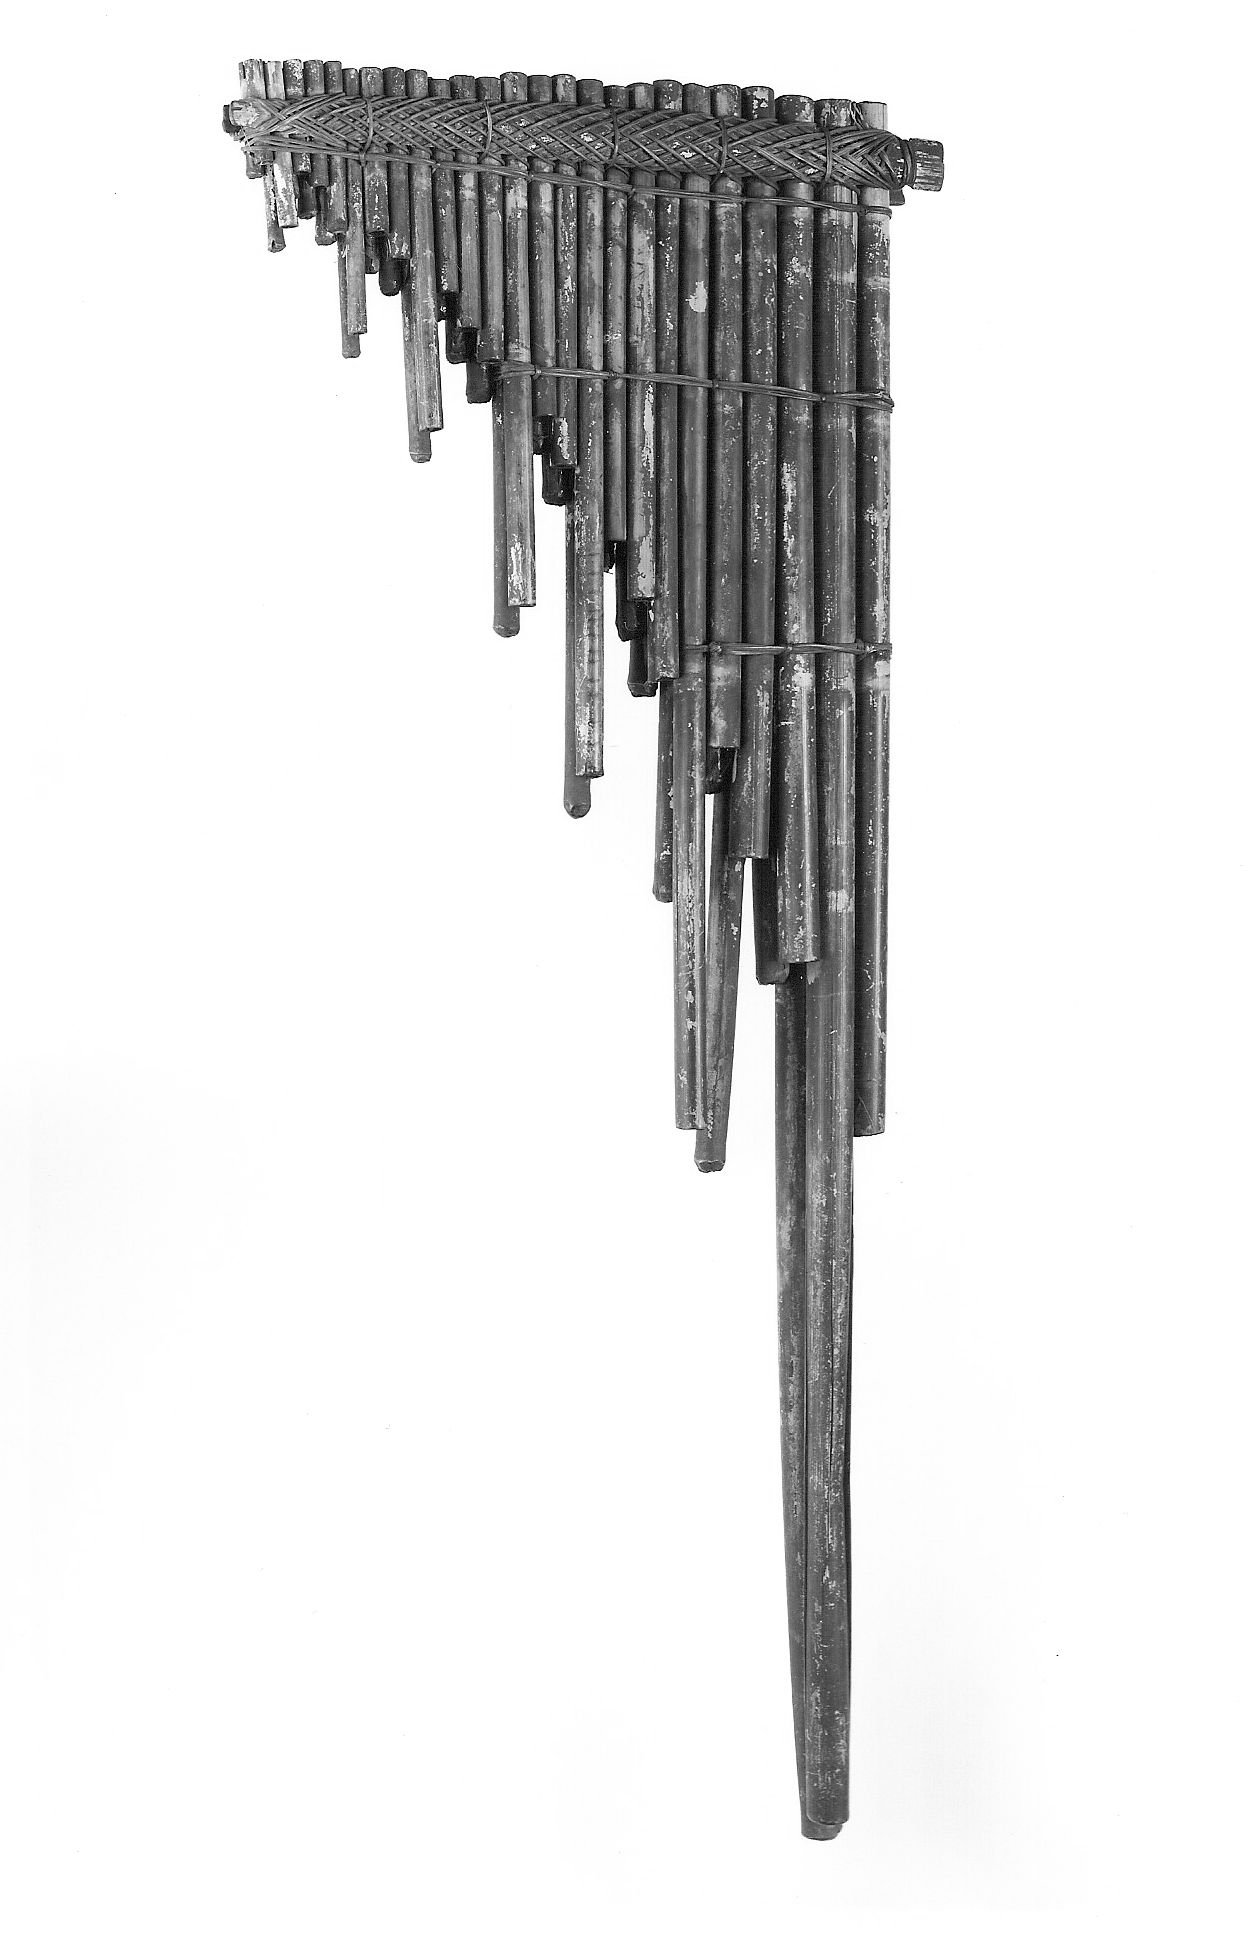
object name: galeon ngungu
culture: melanesian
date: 1867-1900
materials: bamboo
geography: solomon islands